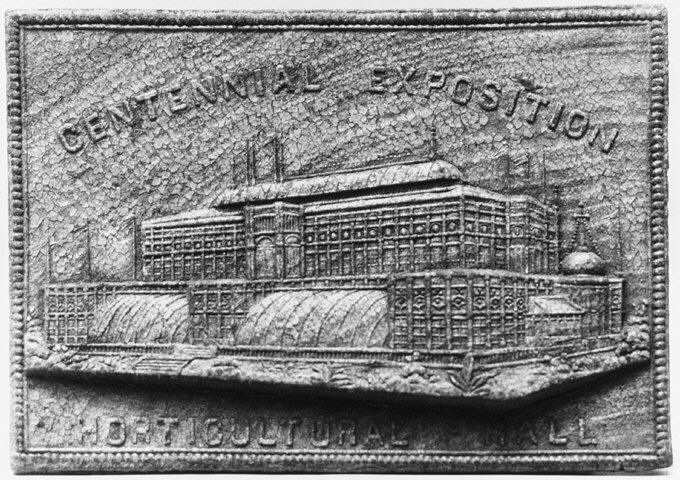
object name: plaque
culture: american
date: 1876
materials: wood